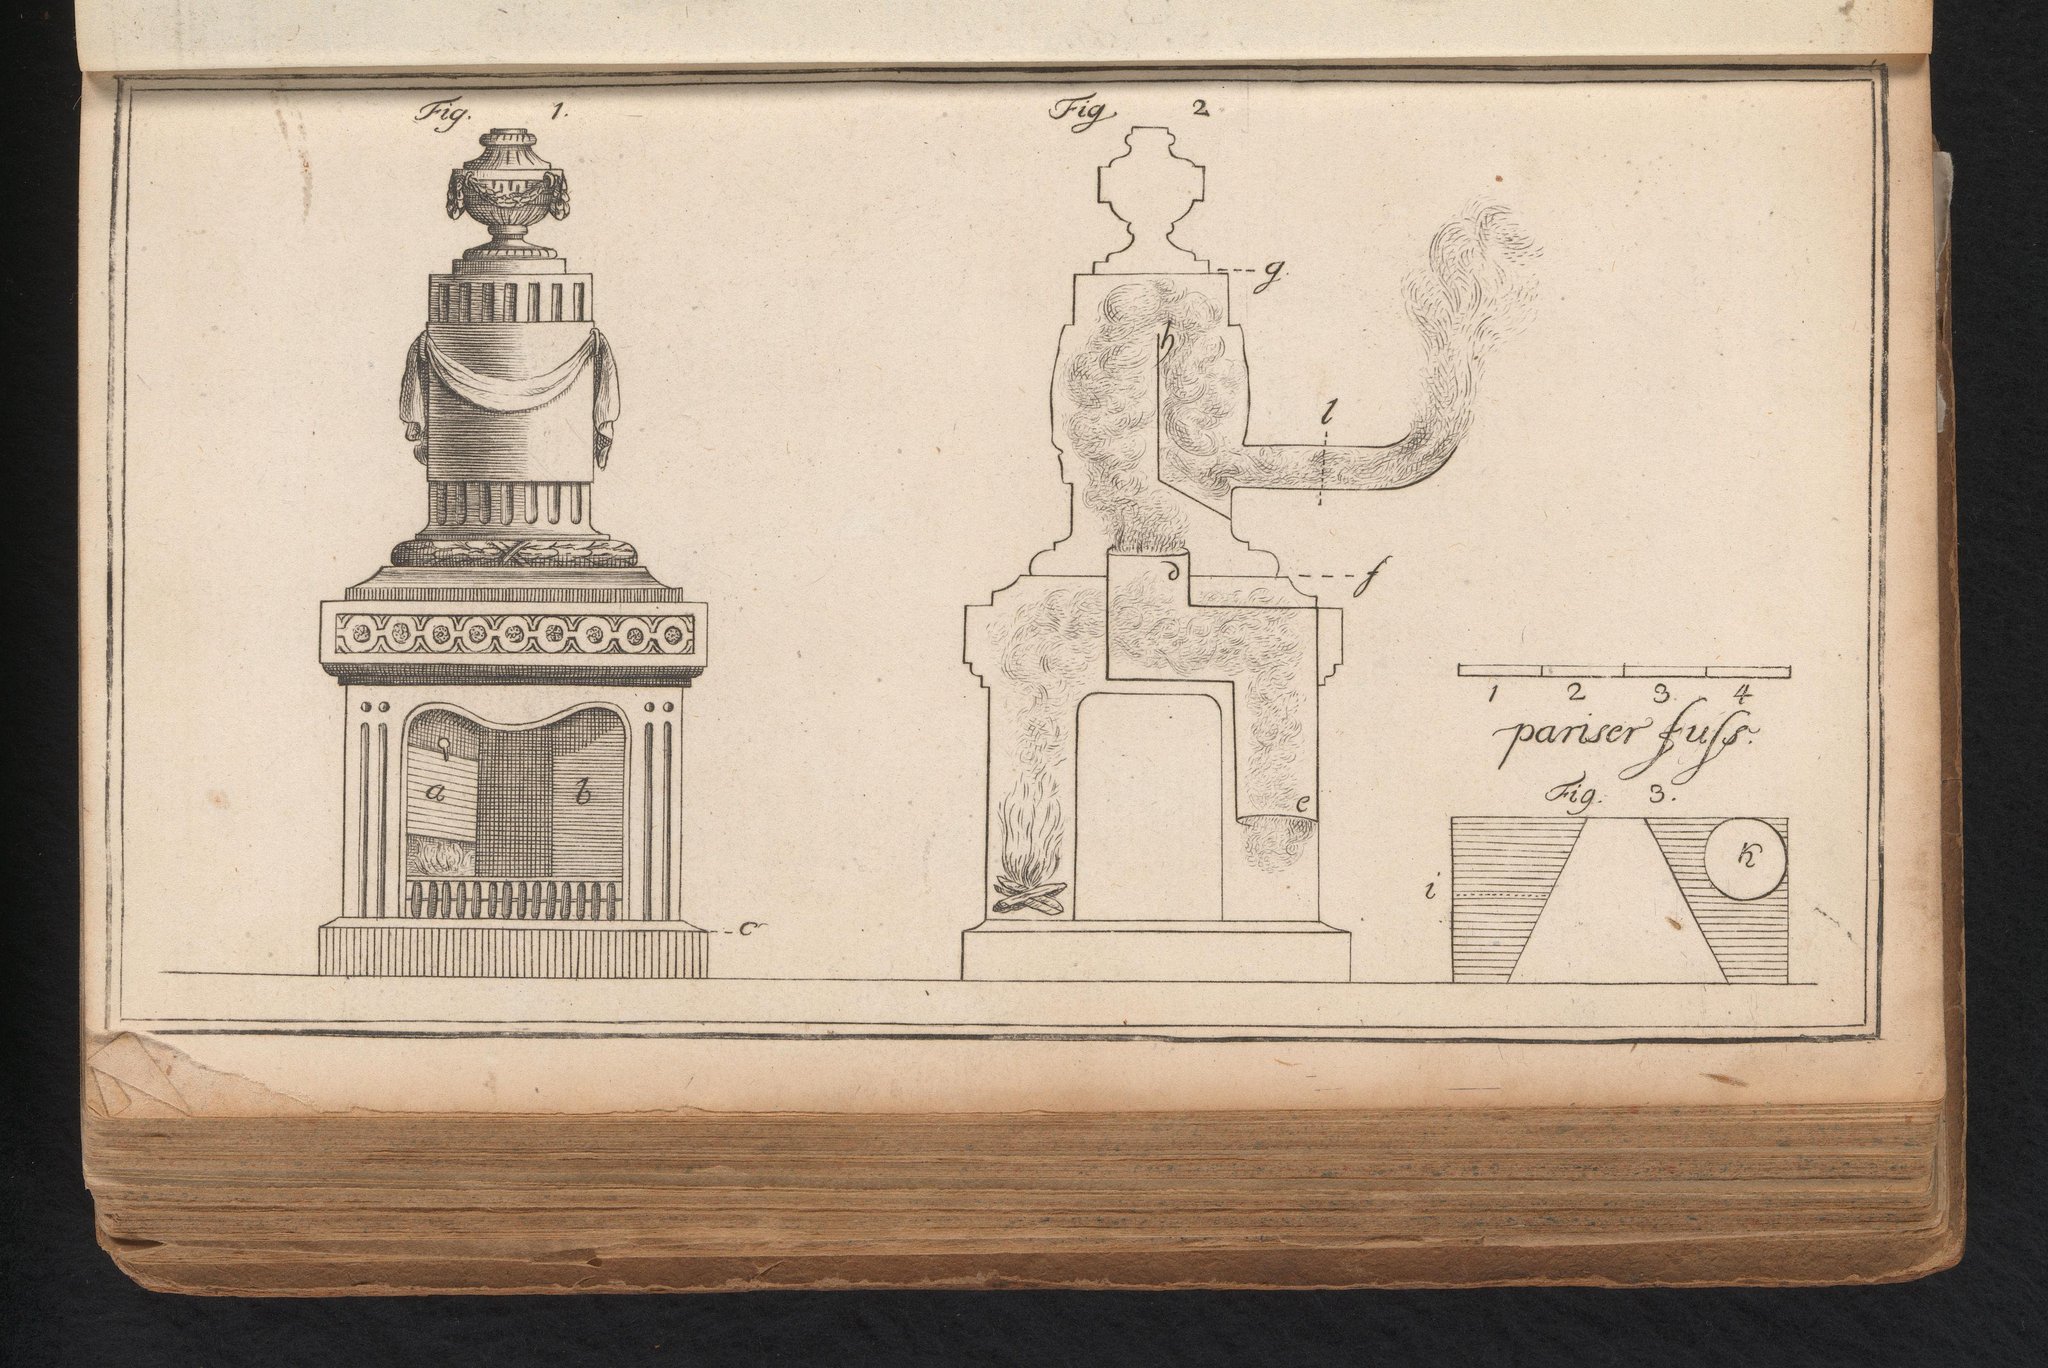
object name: fashion print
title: Journal des Luxus und der Moden 1786, Band I, T. 25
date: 1786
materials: paper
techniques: etching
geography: weimar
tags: fashion plates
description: Oven uitgevonden en ontworpen door de heer Pflugs uit Jena. Prent uit het modetijdschrift Journal des Luxus und der Moden, uitgegeven door Friedrich Justin Bertuch en Georg Melchior Kraus, Weimar, 1786-1826.